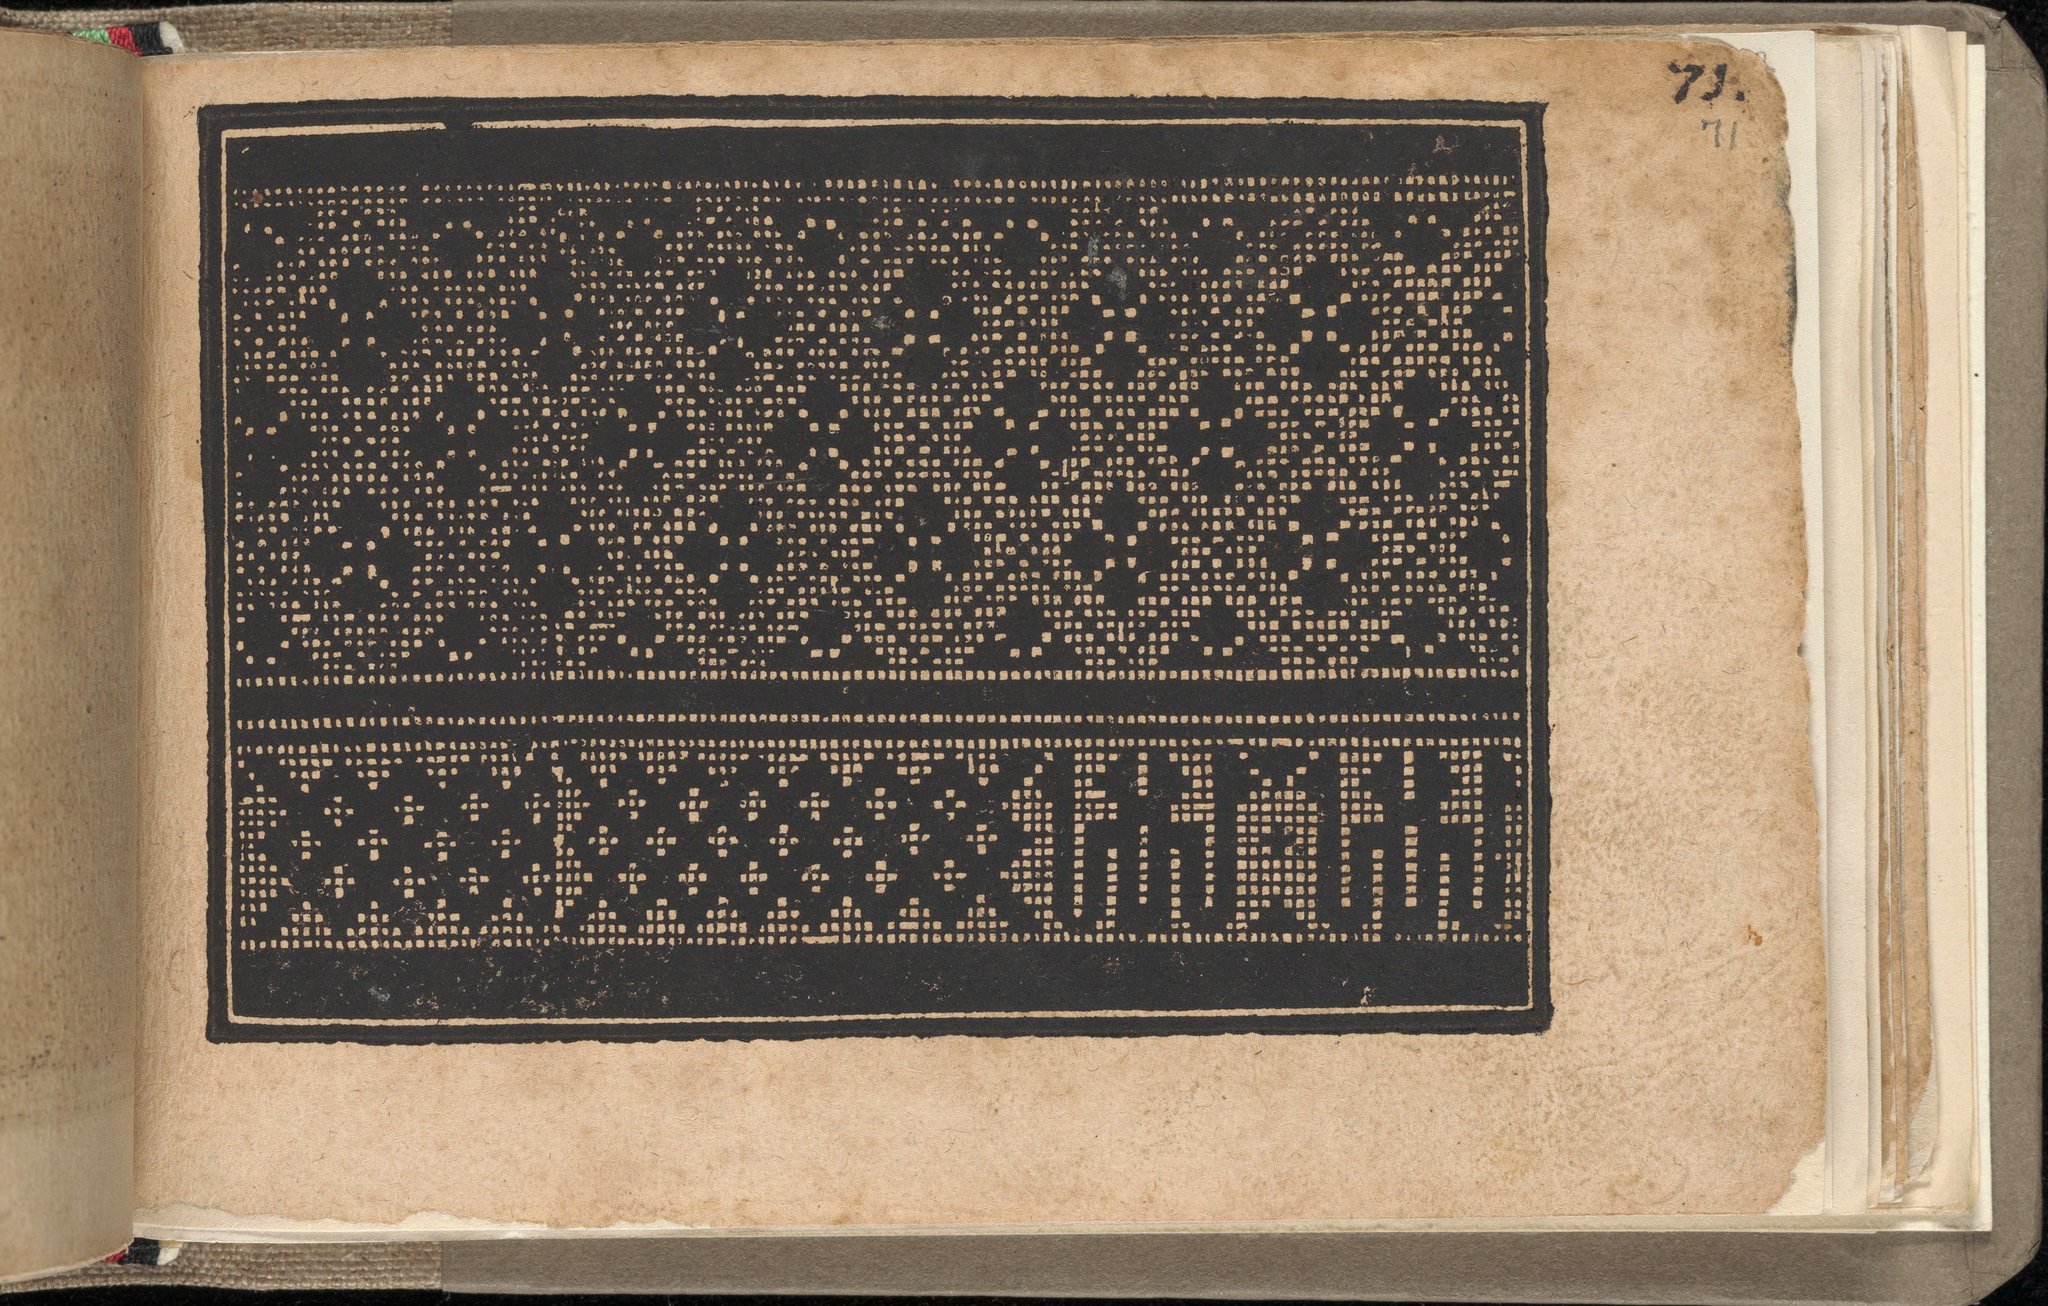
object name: book print ornament architecture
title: Schön newes Modelbuch (Page 71r)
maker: sigismundus latomus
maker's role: publisher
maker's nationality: german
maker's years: 1599-1632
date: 1608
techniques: woodcut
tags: ornament